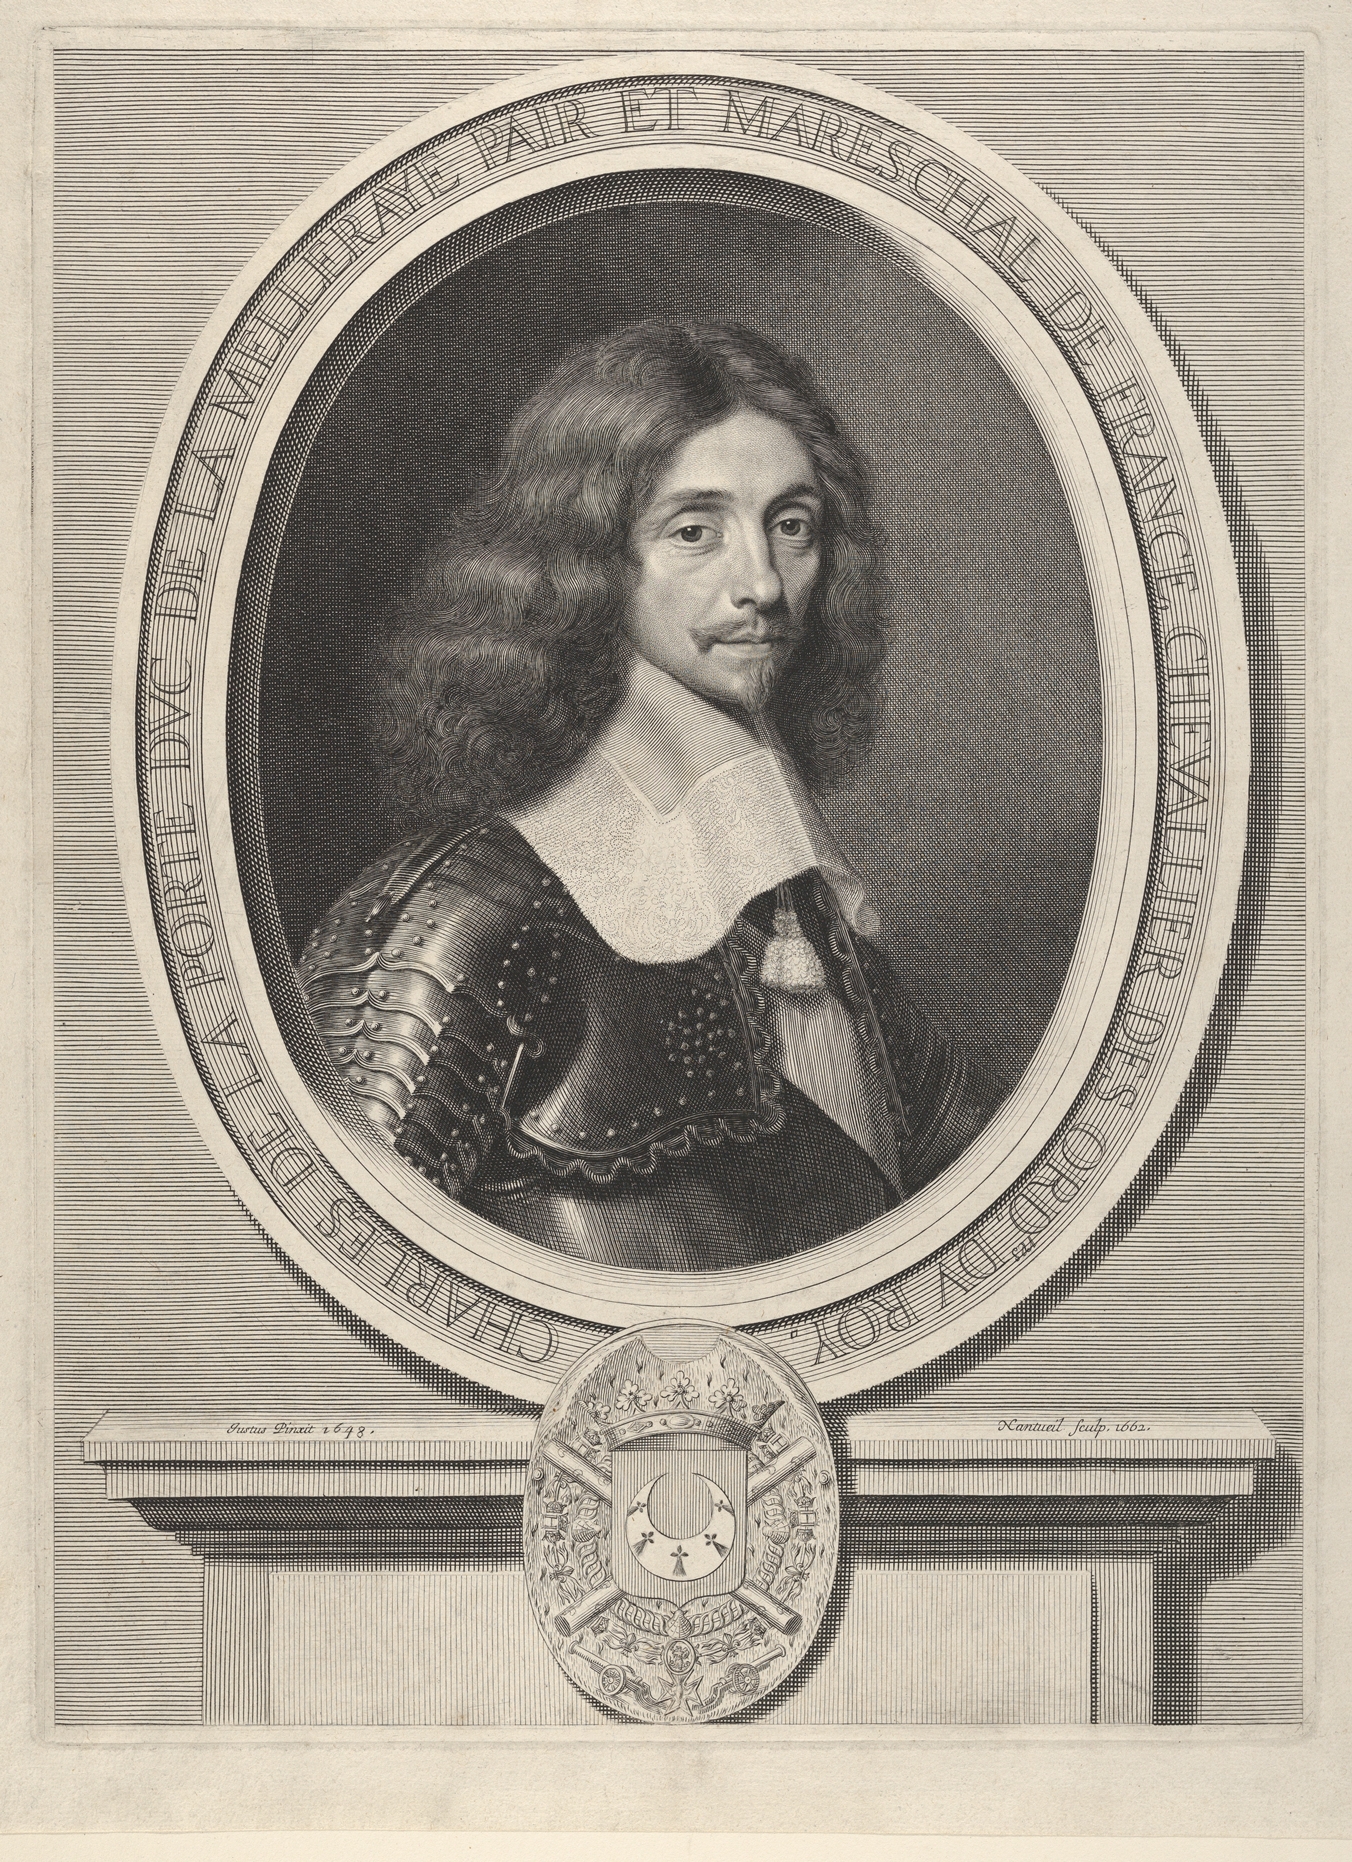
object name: print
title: Charles de La Porte, duc de La Meilleraie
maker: robert nanteuil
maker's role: artist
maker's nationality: french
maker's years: 1623-1678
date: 1662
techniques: engraving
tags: men,portraits